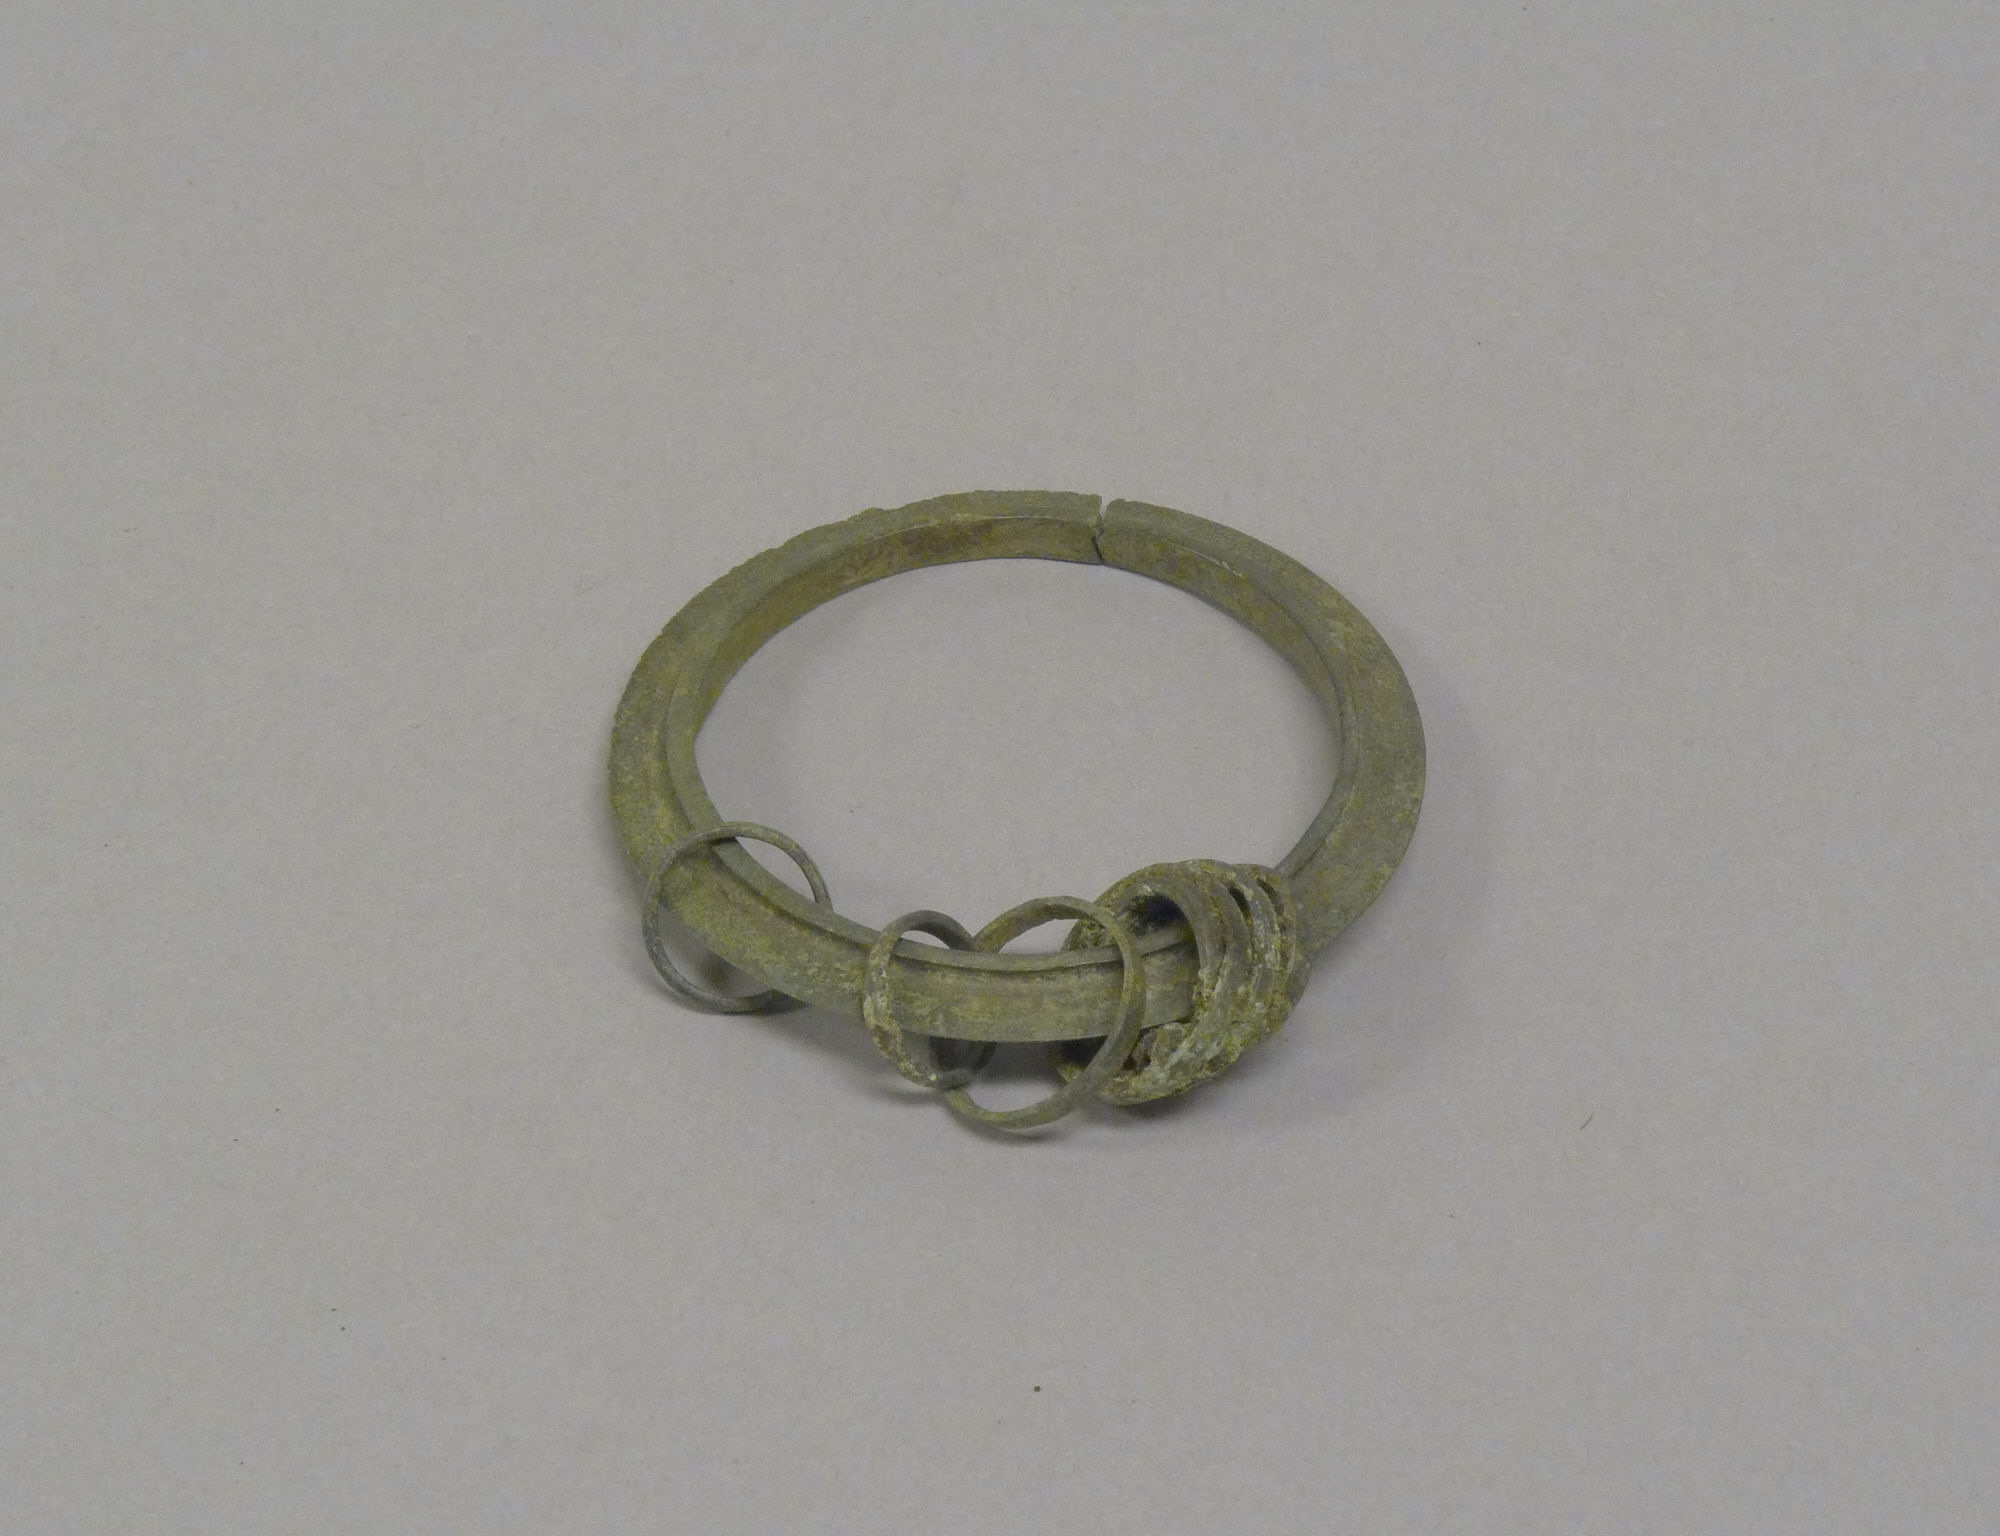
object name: bangle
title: Bangle with Rings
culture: thai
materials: bronze